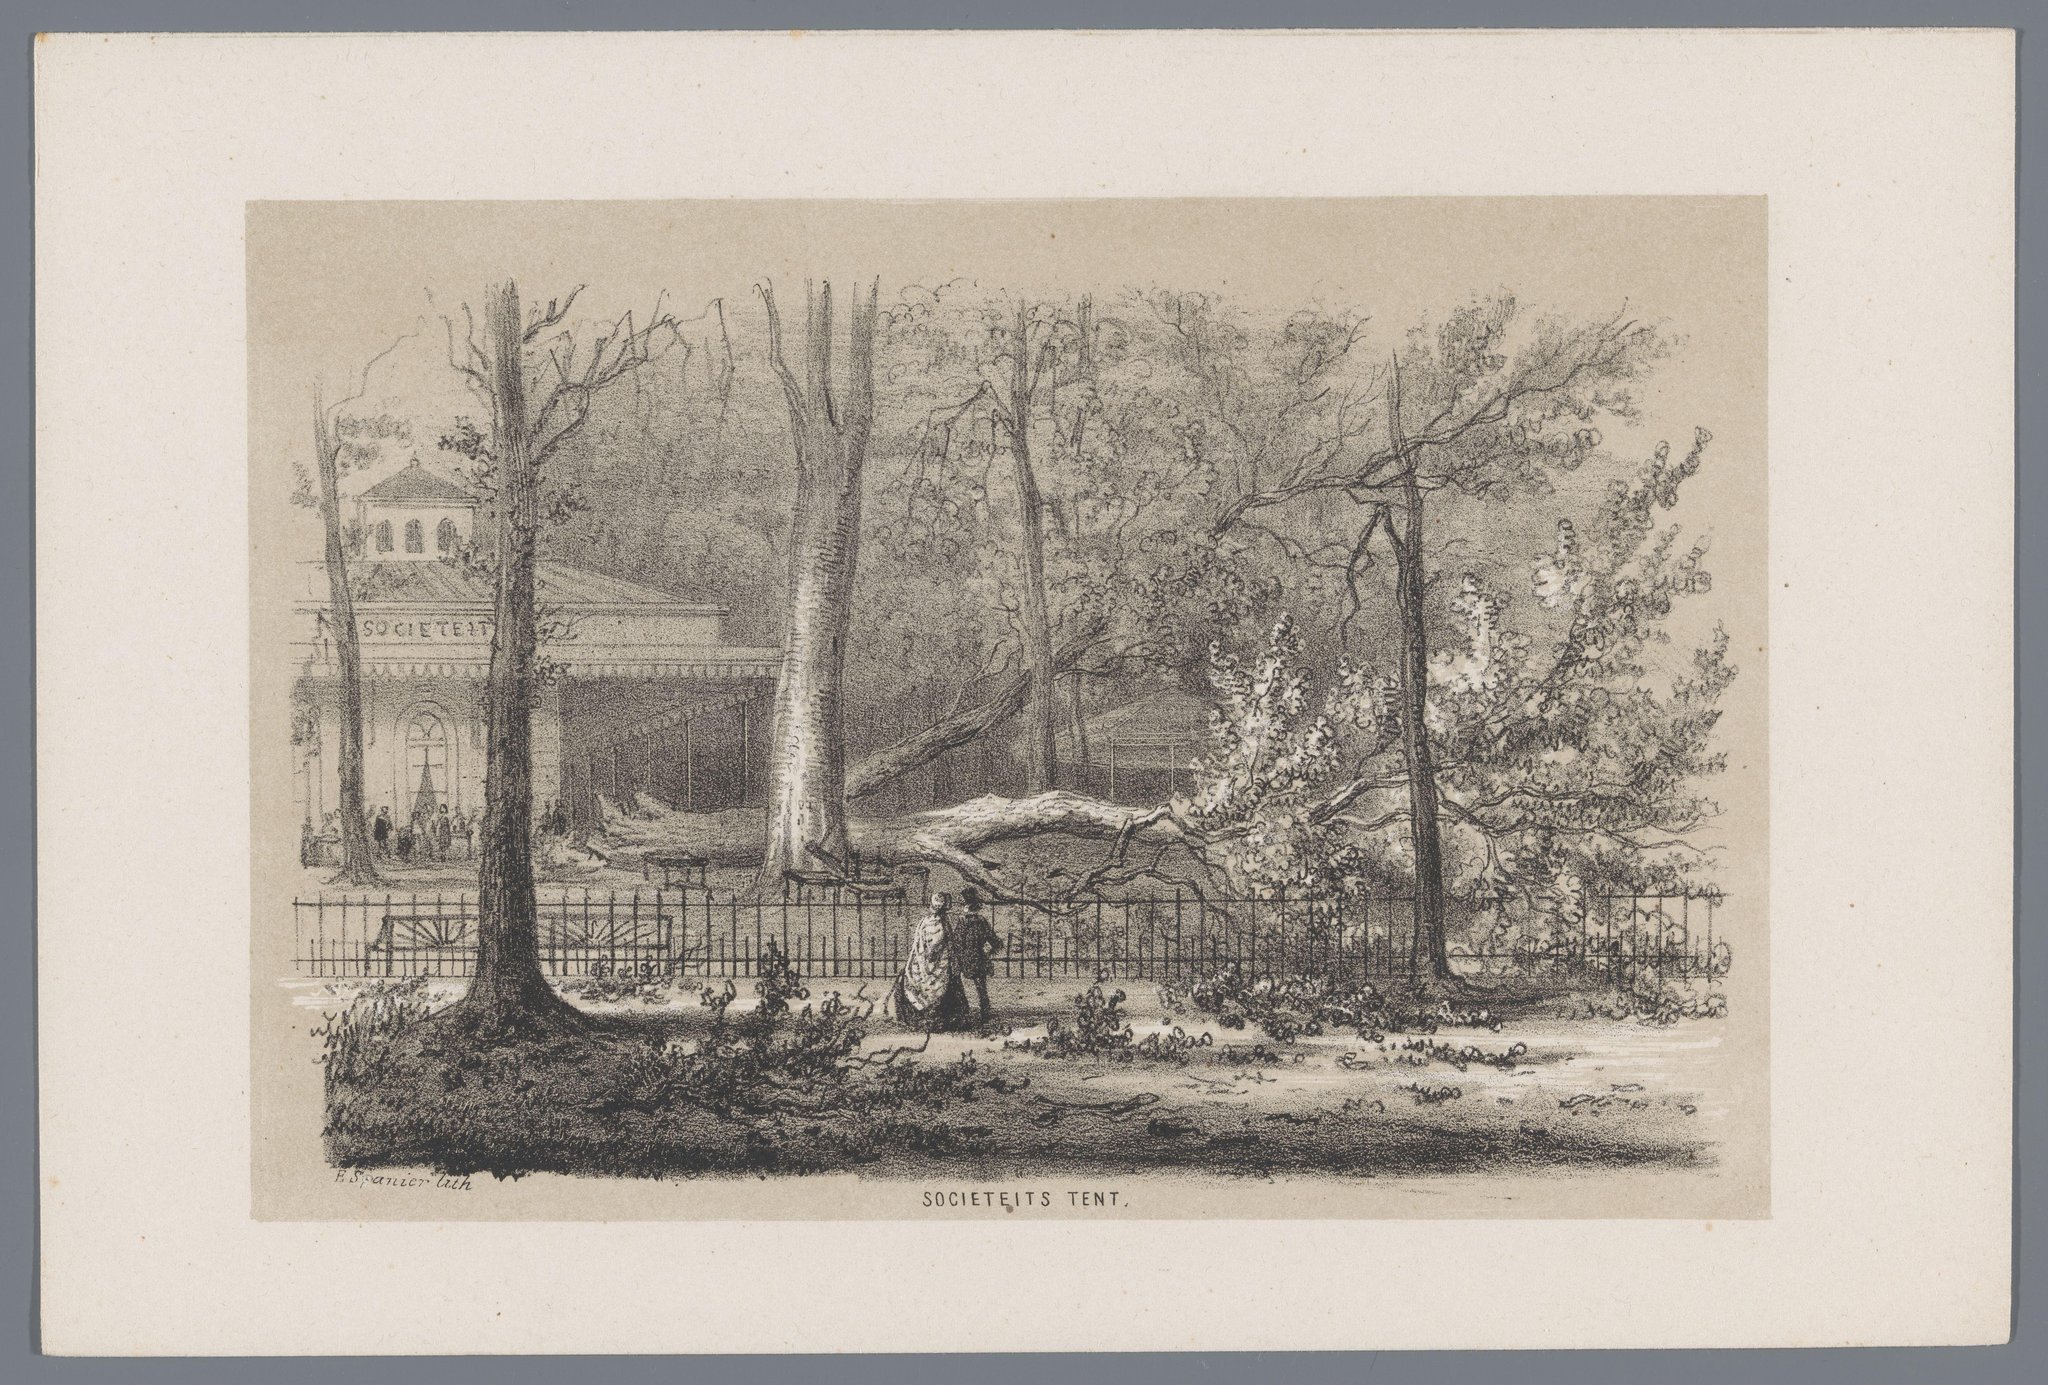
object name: print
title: Sociteits Tent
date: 1860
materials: paper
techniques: tone lithography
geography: the hague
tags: storm on land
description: Een omgewaaide boom bij de Sociëteits Tent, na de storm. Onderdeel van het album met tien losse steendrukken in een papieren omslag met voorstellingen van de schade aangericht door de 'Pinksterstorm' van 28 mei 1860 in het Haagse Bos en omgeving.